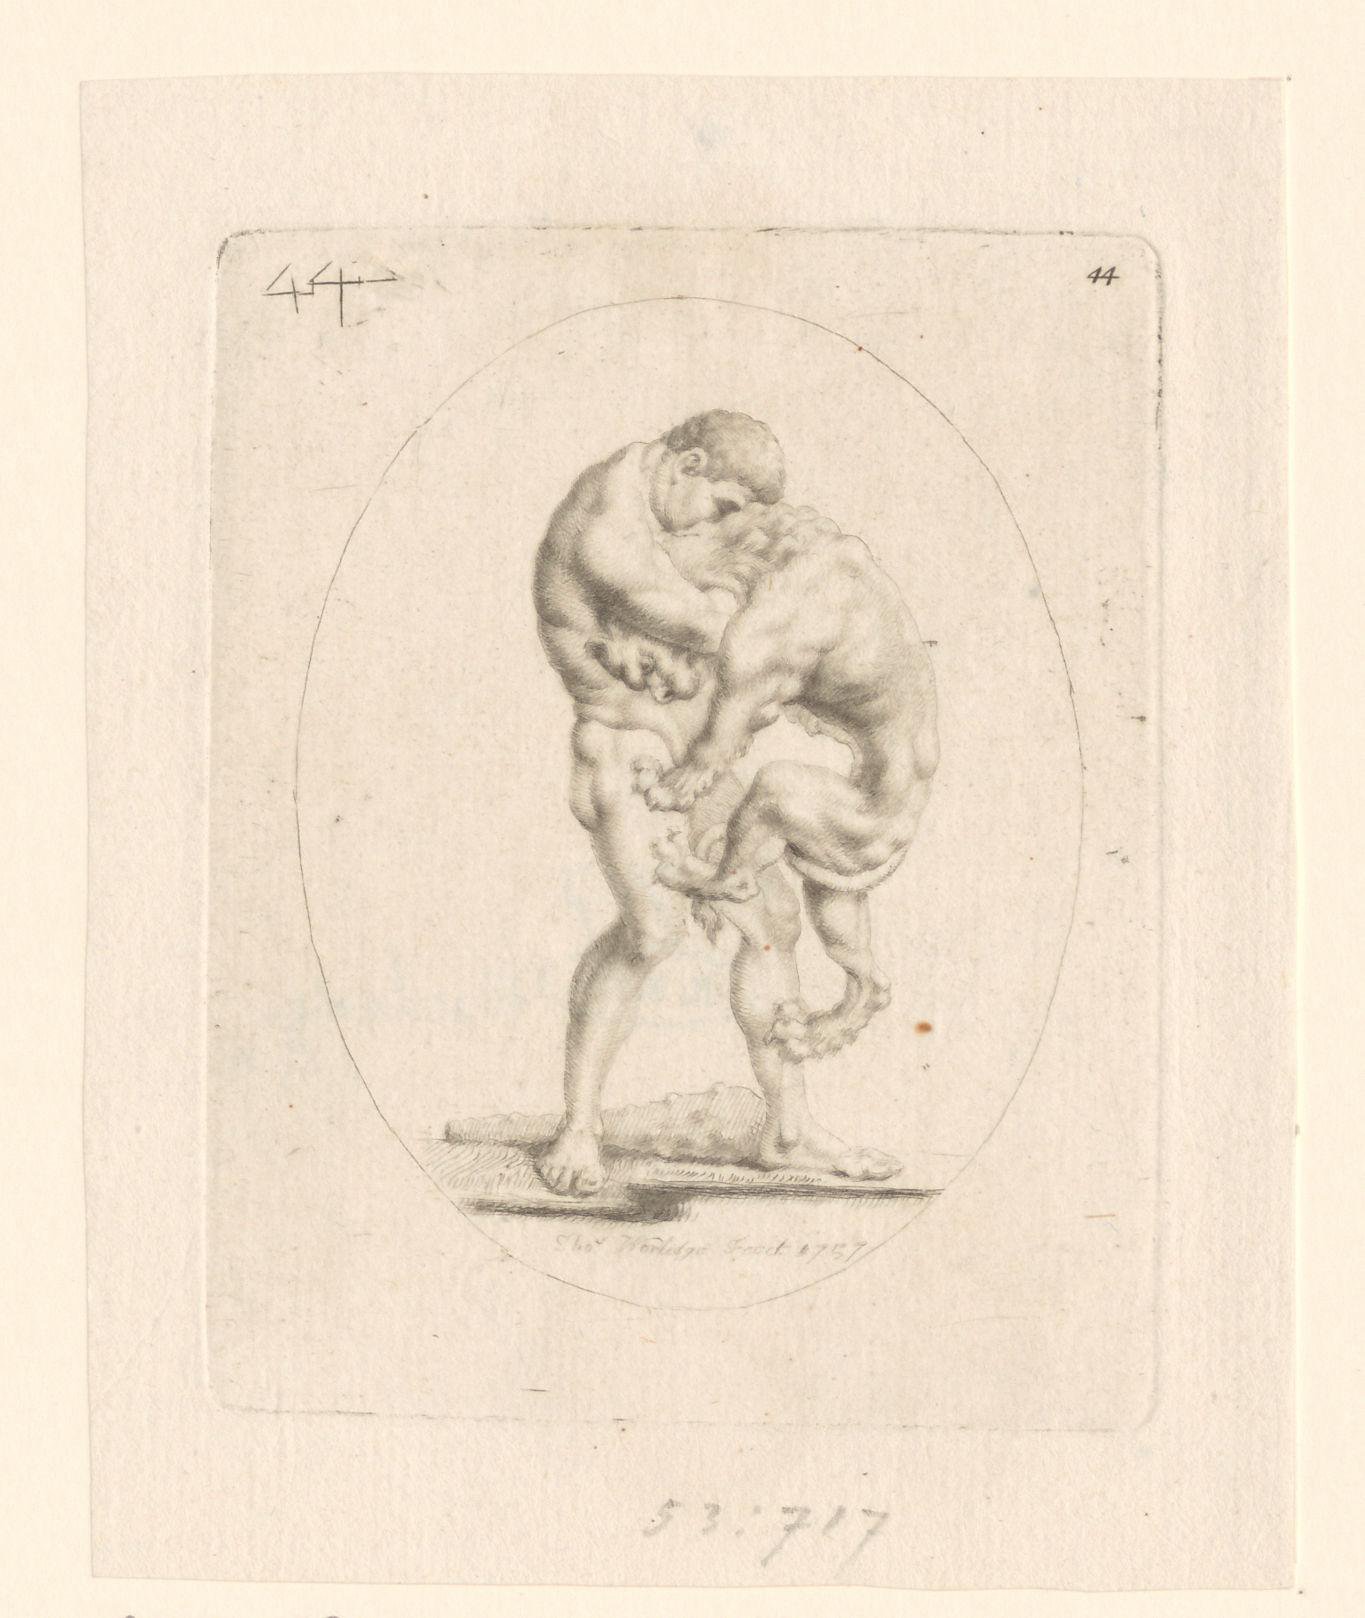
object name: print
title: Prenten naar antieke edelstenen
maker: thomas worlidge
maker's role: print maker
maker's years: 1700-1766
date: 1757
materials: paper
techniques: drypoint, etching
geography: london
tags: (1) hercules chokes the nemean lion with his arms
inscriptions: collector's mark: Lugt 2760, collector's mark: Lugt 2228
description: Worlidge maakte prenten voor de serie vanaf ca. 1754. Na zijn dood werden de prenten gebundeld in: Worlidge, Thomas. A Select Collection of Drawings from Curious Antique Gems (...). Londen: M. Worlidge, 1768.